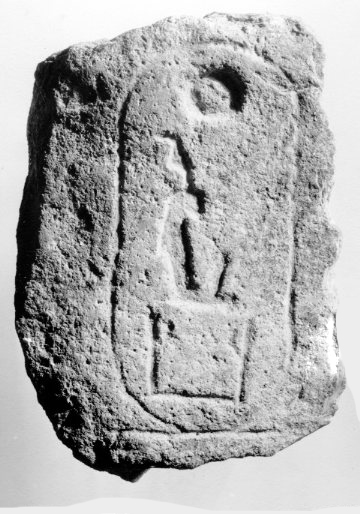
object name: inscribed stone, hatshepsut, maatkare, hieratic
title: Inscribed Stone from Hatshepsut's Valley Temple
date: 1479-1458 BCE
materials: ink, quartzite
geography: egypt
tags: hieroglyphs